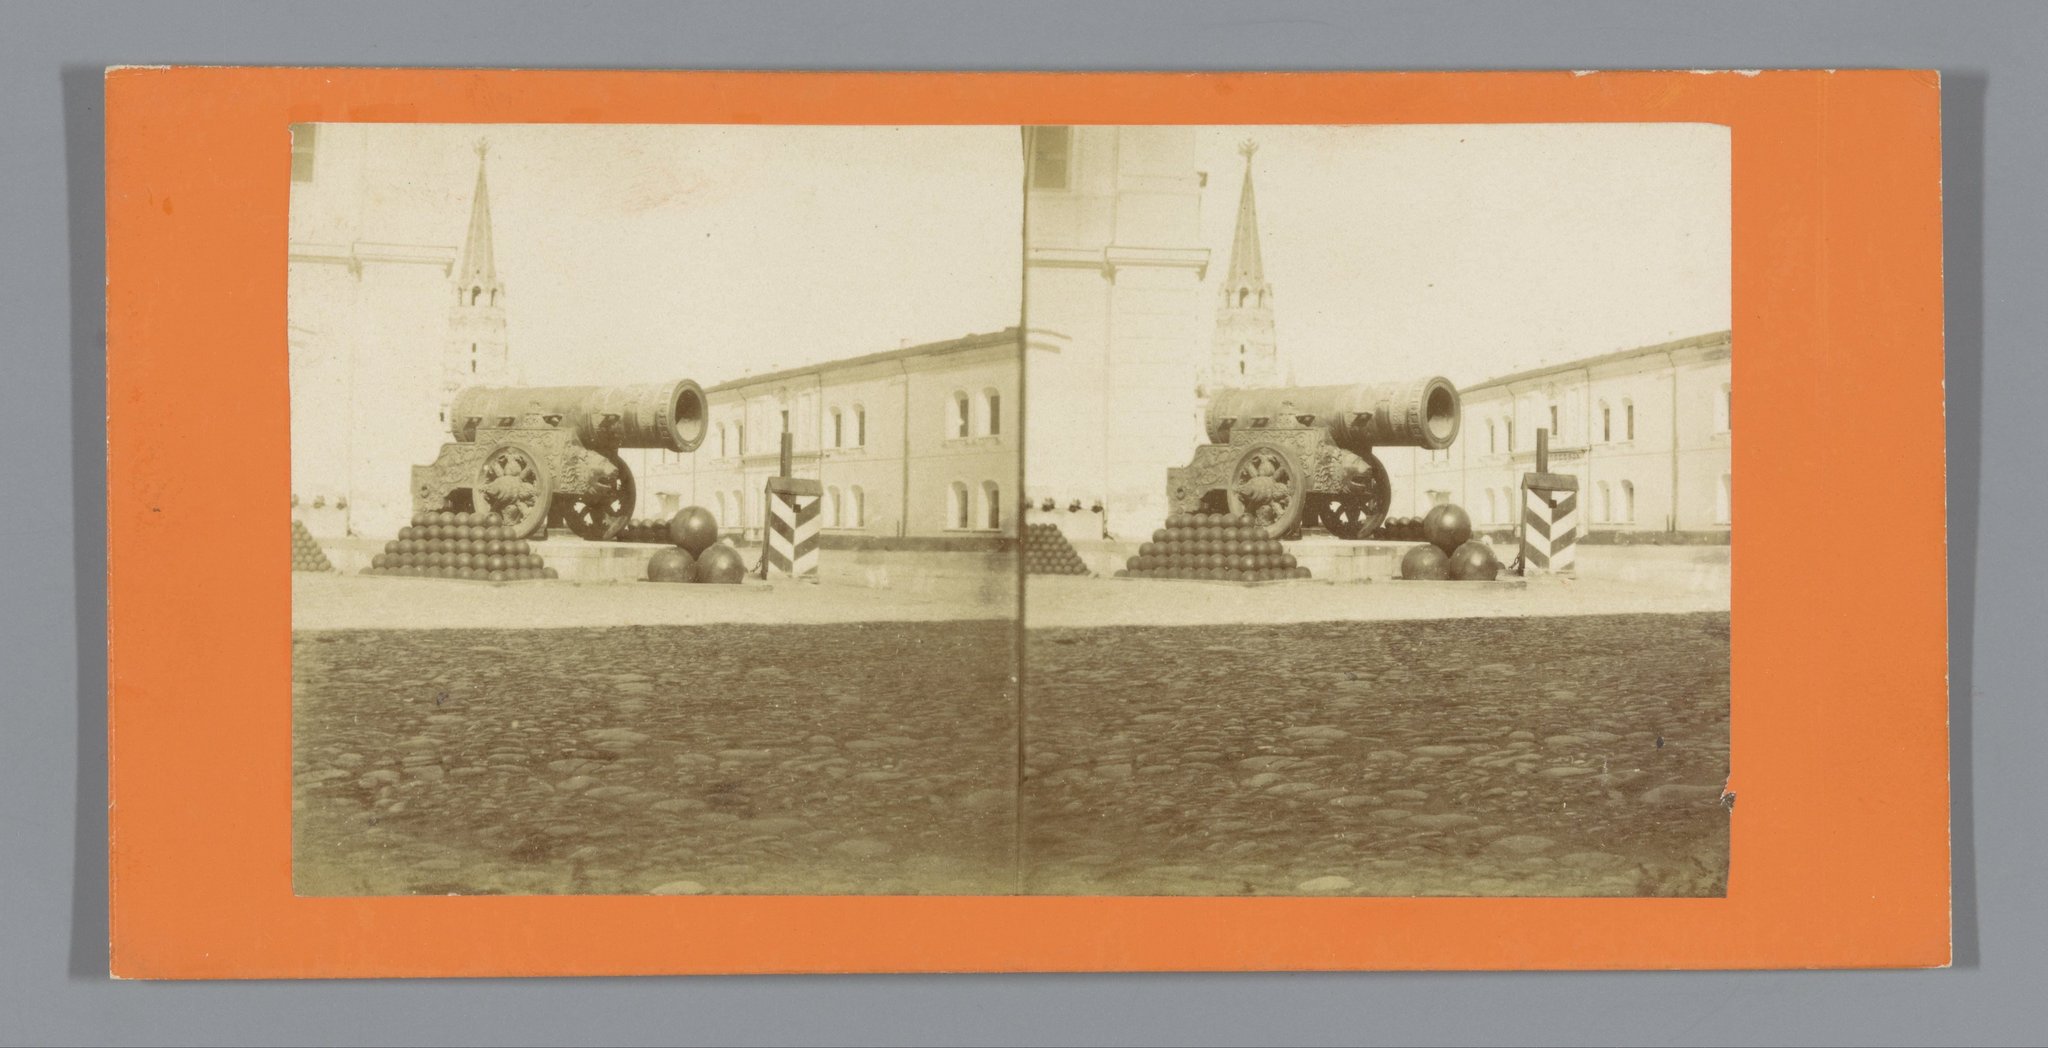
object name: stereograph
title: Tsarenkanon in het Kremlin te Moskou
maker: Anonymous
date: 1850-1880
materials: cardboard, photographic support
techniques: albumen print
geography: moscow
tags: firearms: cannon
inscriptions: inscription: ‘48 Le Canon l'empereur Moscou’